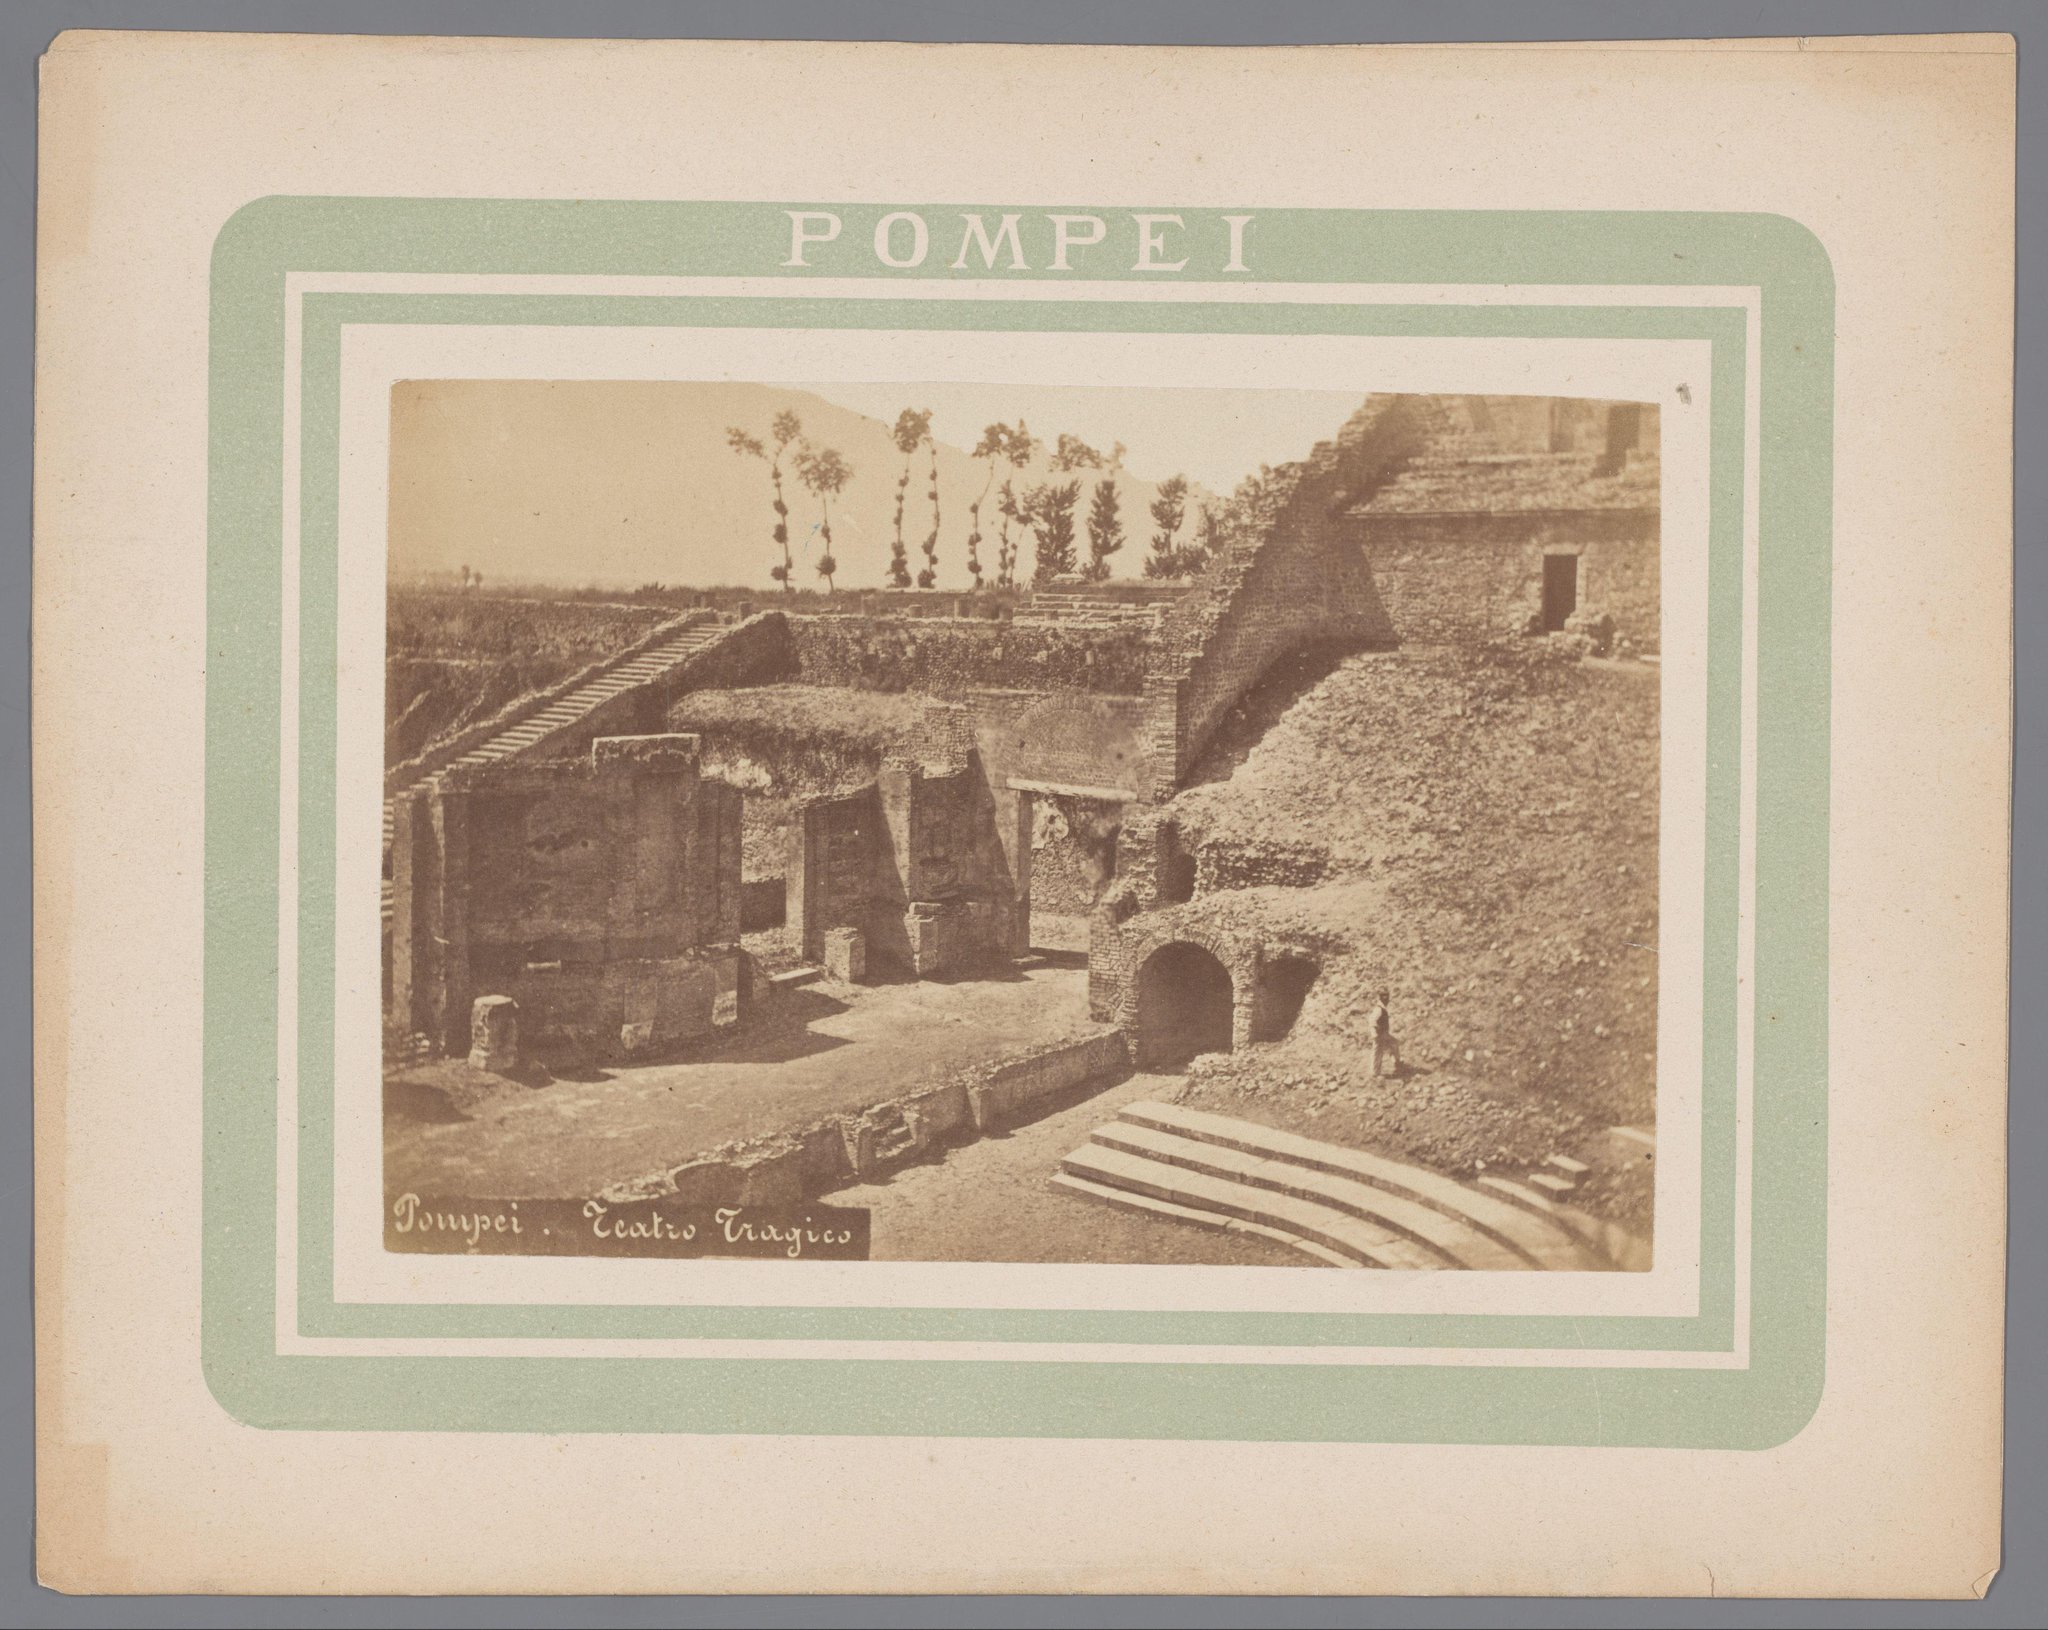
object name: photograph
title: Pompei. Teatro Tragico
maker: giorgio sommer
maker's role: fotograaf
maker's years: 1834-1914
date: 1857-1914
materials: cardboard, paper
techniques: albumen print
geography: pompeii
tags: ruin of a building ~ architecture, theatre (building)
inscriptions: inscription: ‘10’, collector's mark: ‘VOSMAER’